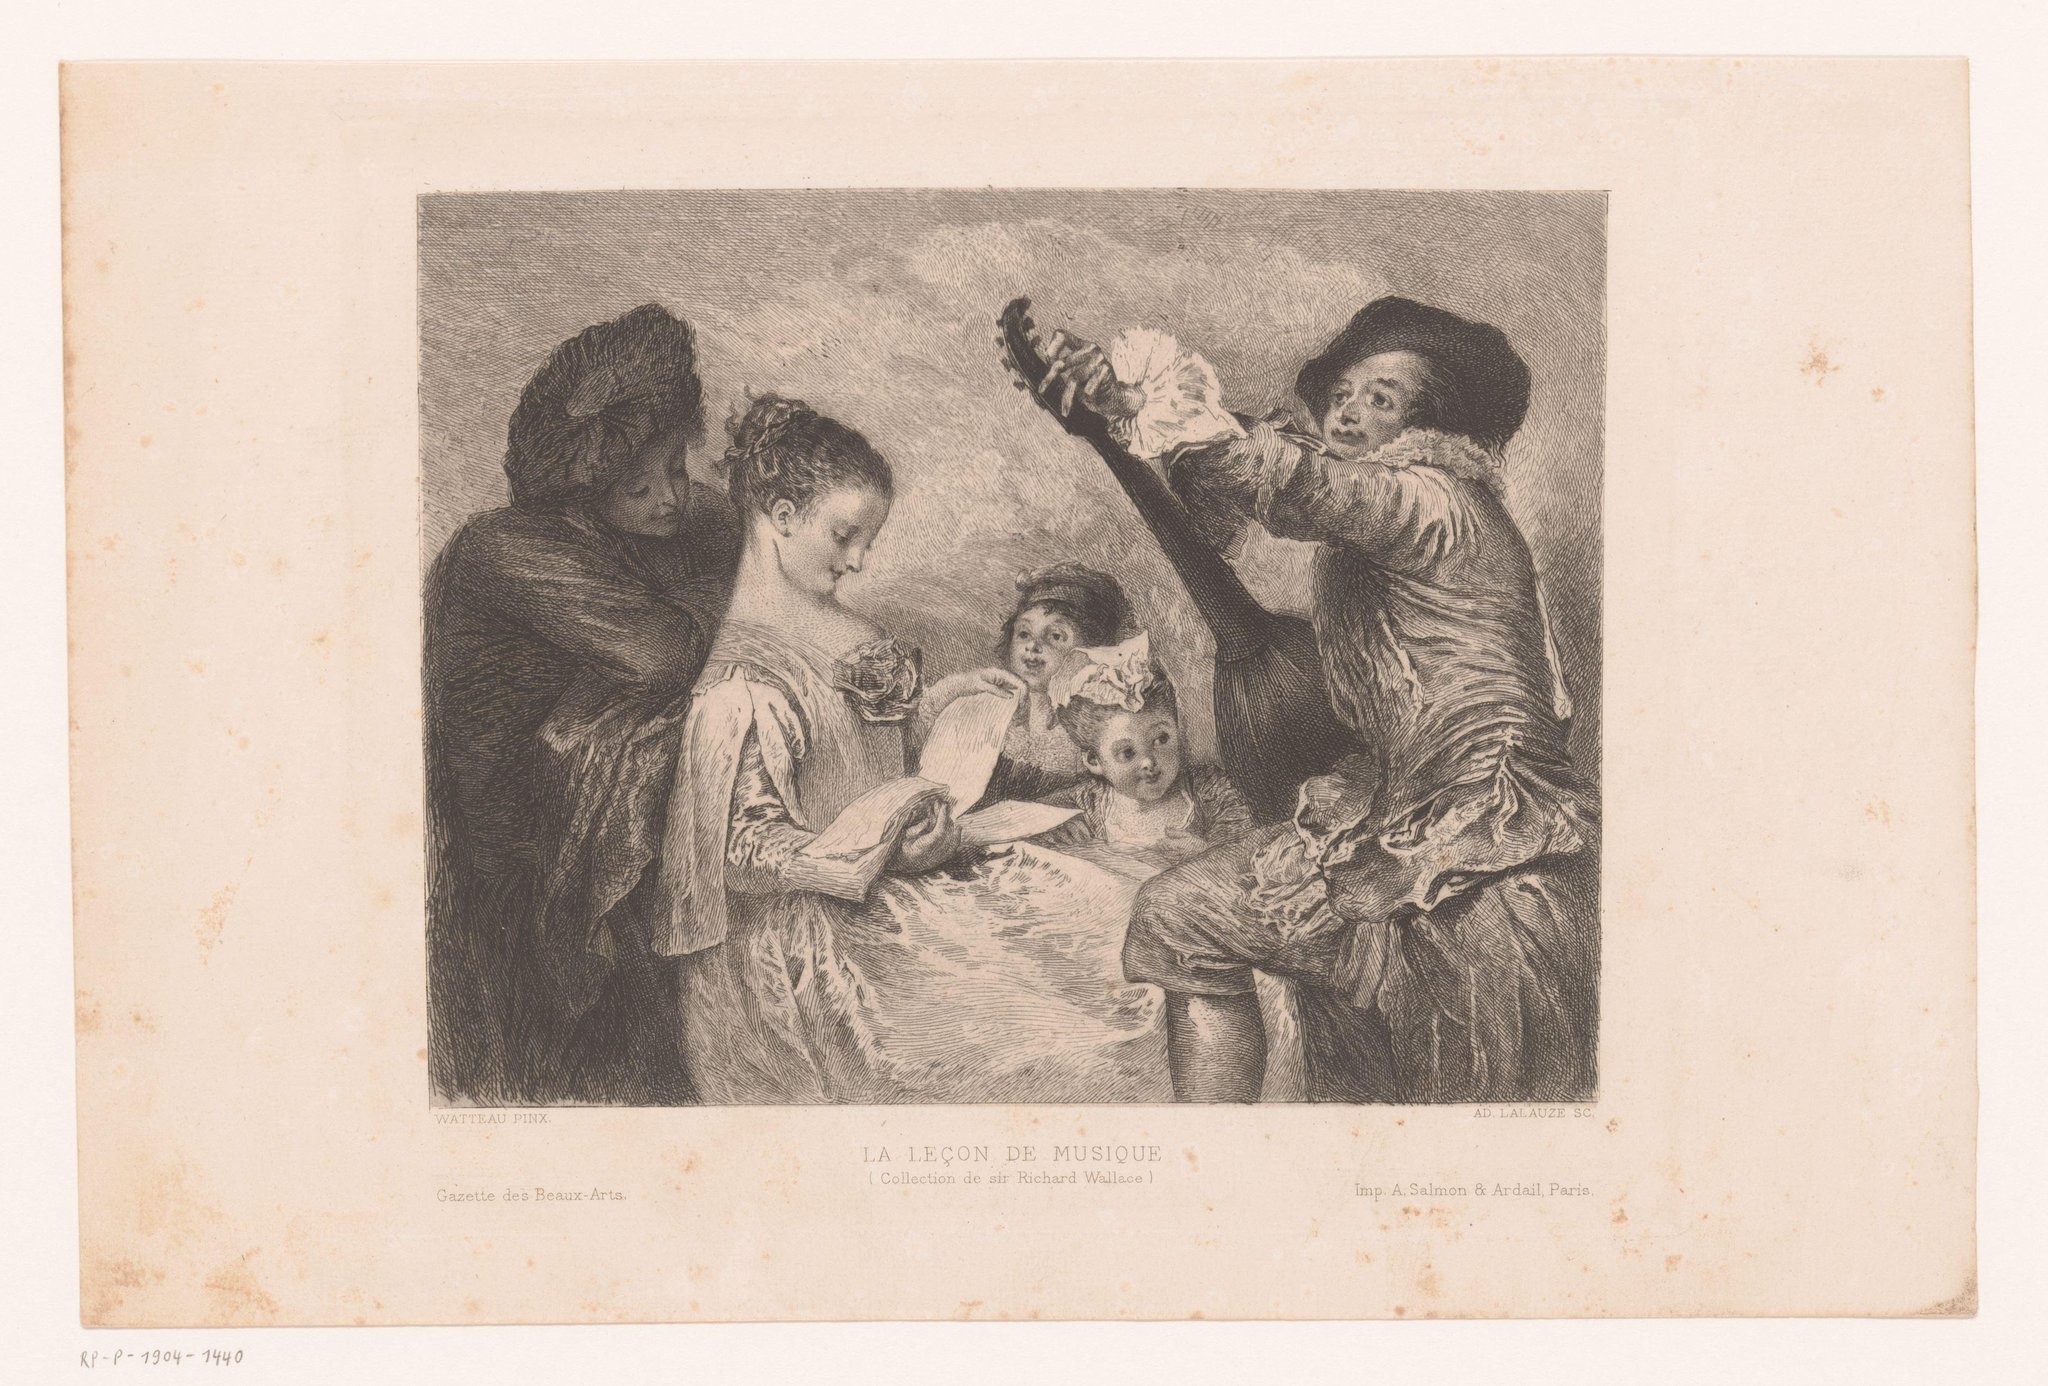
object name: print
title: La leçon de musique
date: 1890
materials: paper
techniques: engraving, etching, intaglio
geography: paris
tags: musician - cc - out of doors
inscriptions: collector's mark: Lugt 2228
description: Gepubliceerd in: "Gazette des Beaux-Arts", 1890, p. 226.